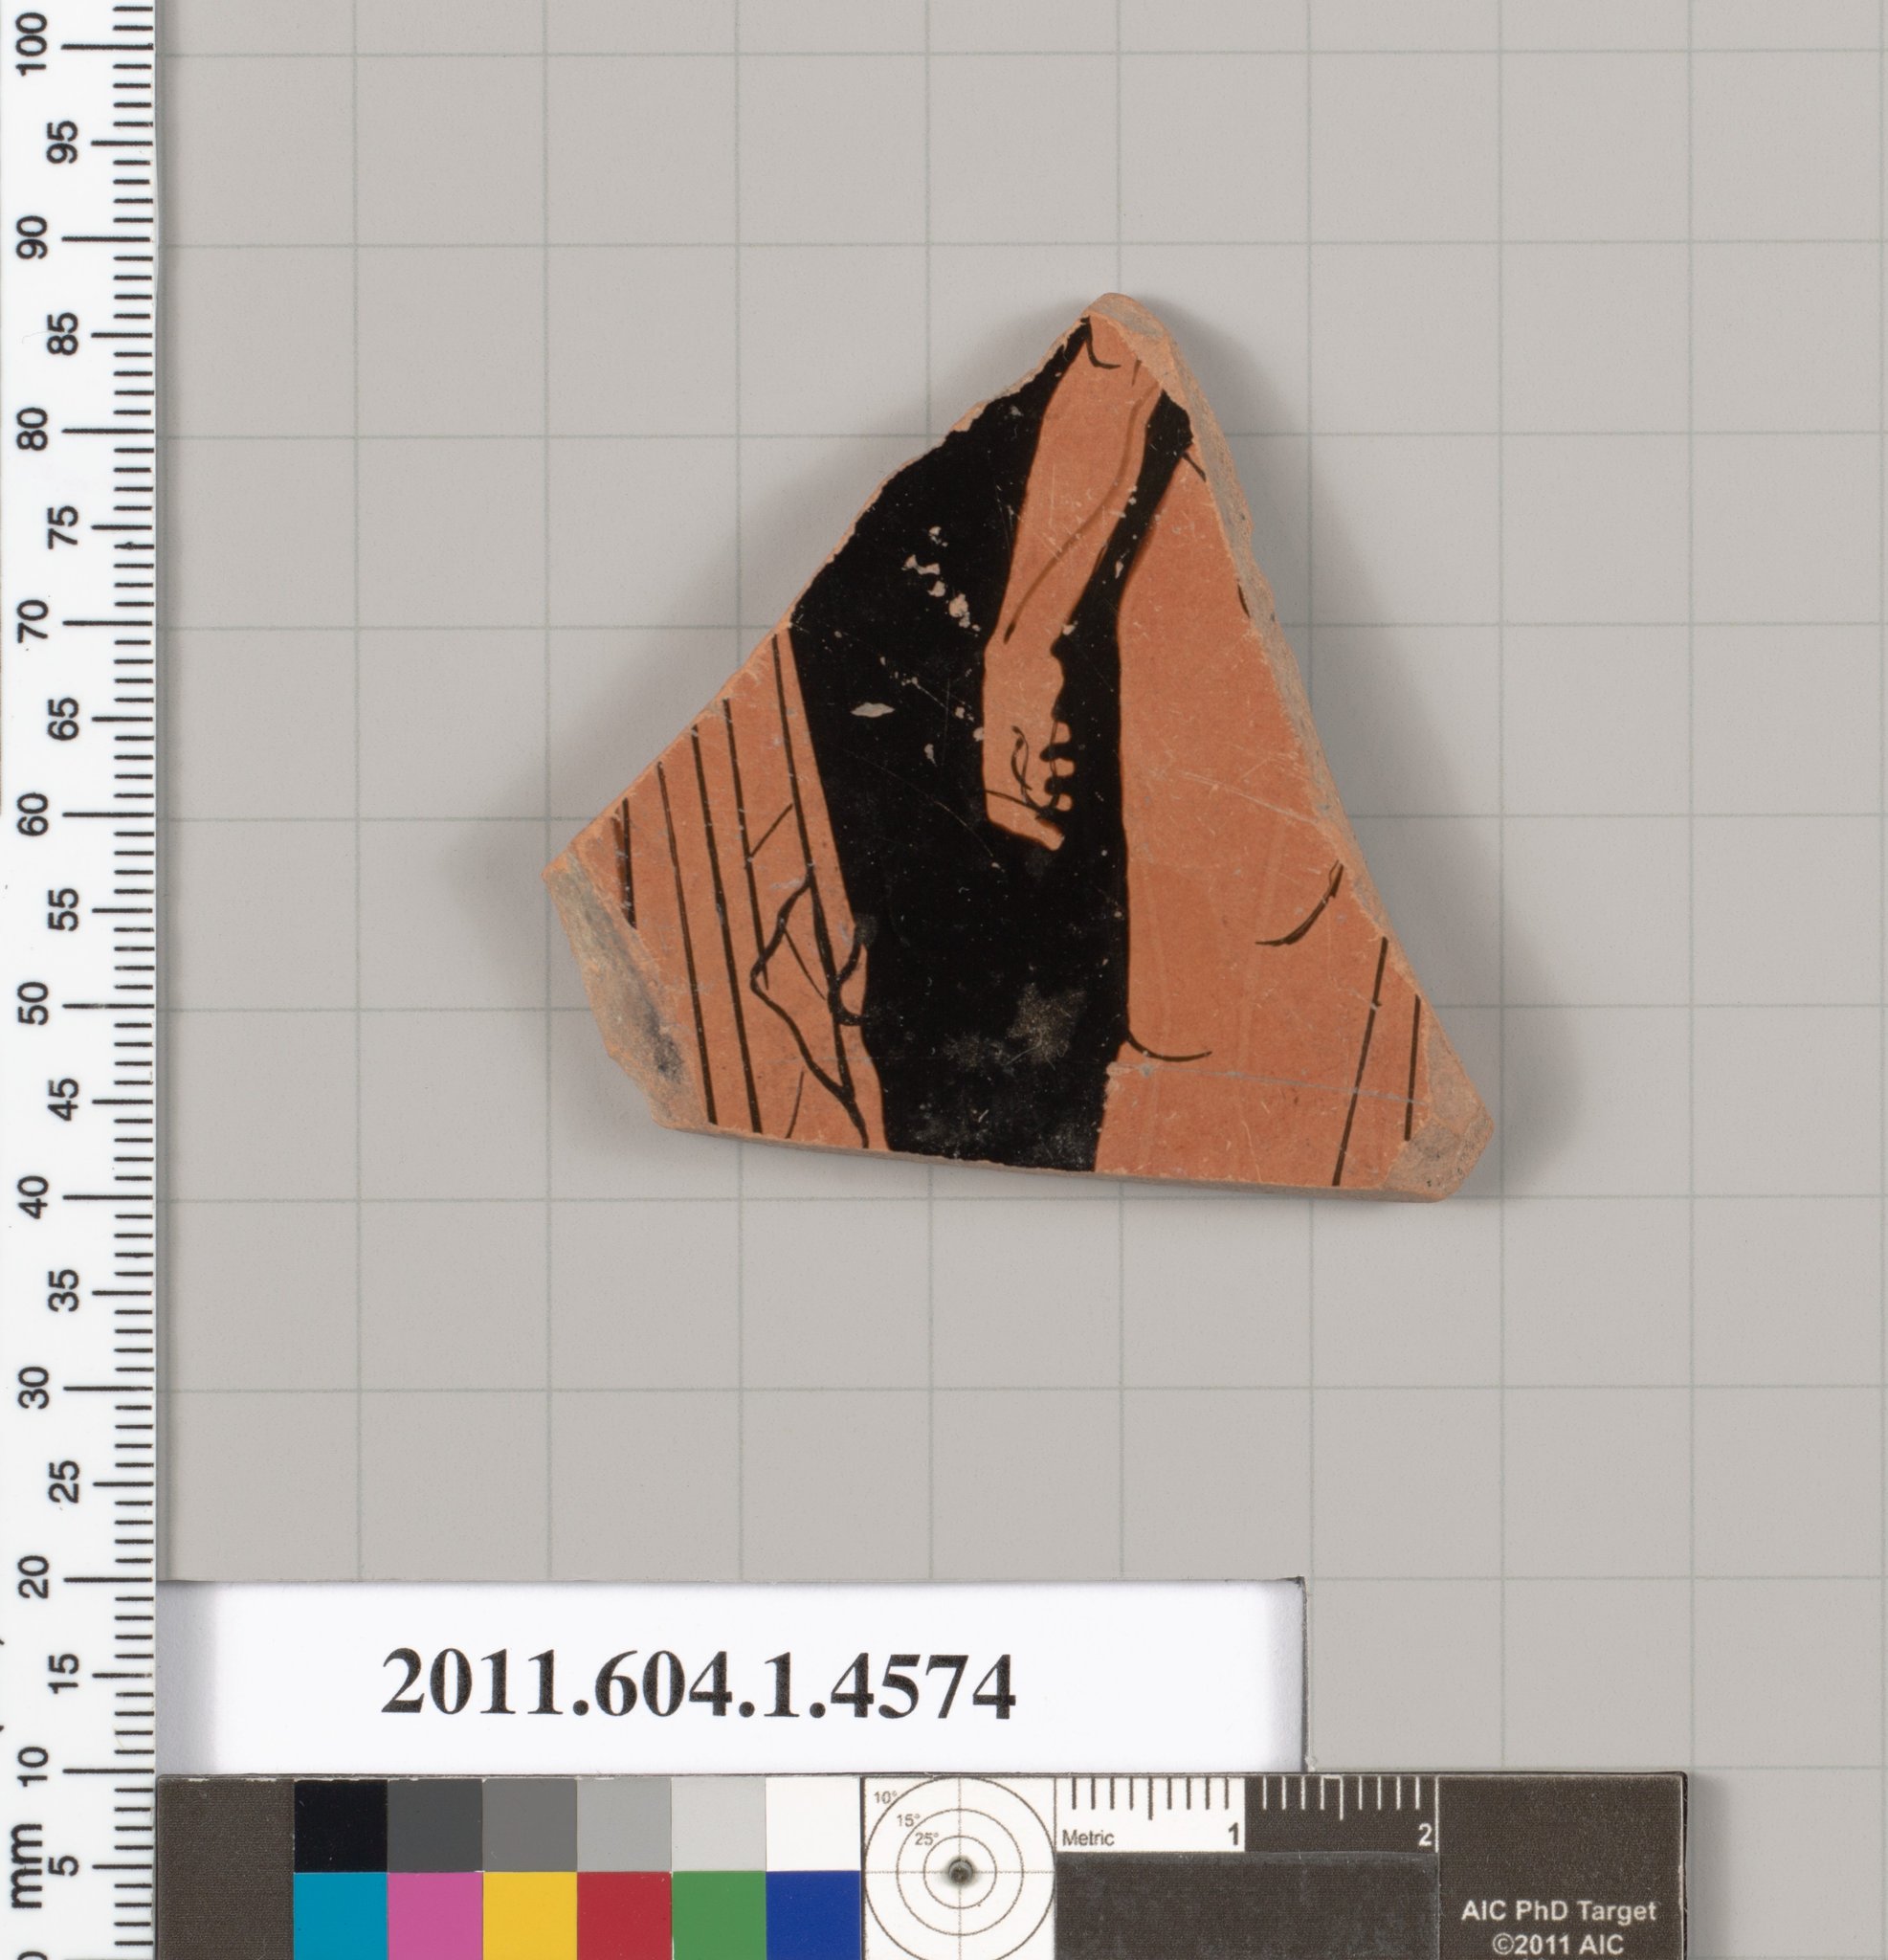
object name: kylix fragment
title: Terracotta fragment of a kylix (drinking cup)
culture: greek, attic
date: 475-451 BCE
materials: terracotta